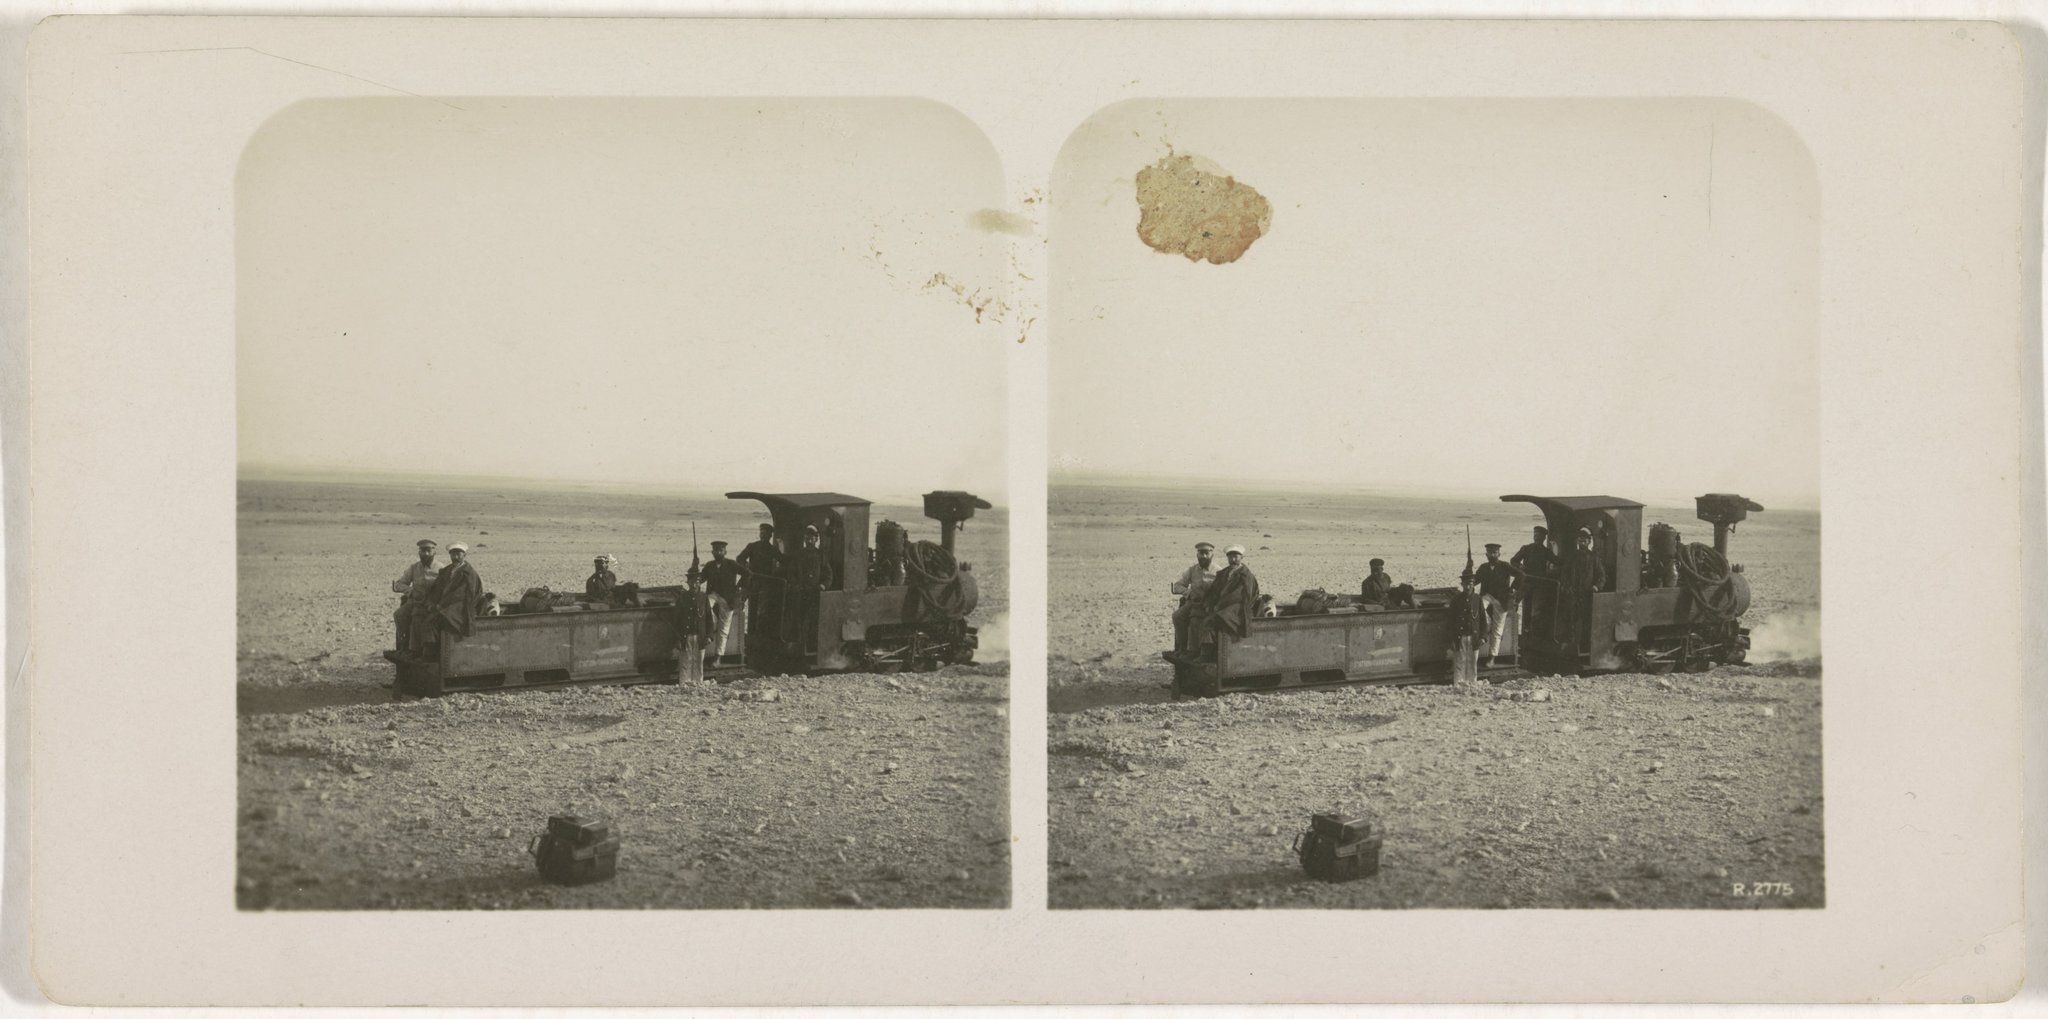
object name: stereograph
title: Locomotief met mensen in de Namib-woestijn, Zuidwest-Afrika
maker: Anonymous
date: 1884-1914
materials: cardboard, paper, photographic support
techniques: gelatin silver print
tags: namibië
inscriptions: title: ‘Süd-West-Afrika / 2775. / Durch die Wüste Namib mit der Locomotive / Through the desert Namib with the Locomotive...’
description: Rechtsonder op de foto rechts staat: R.2775.